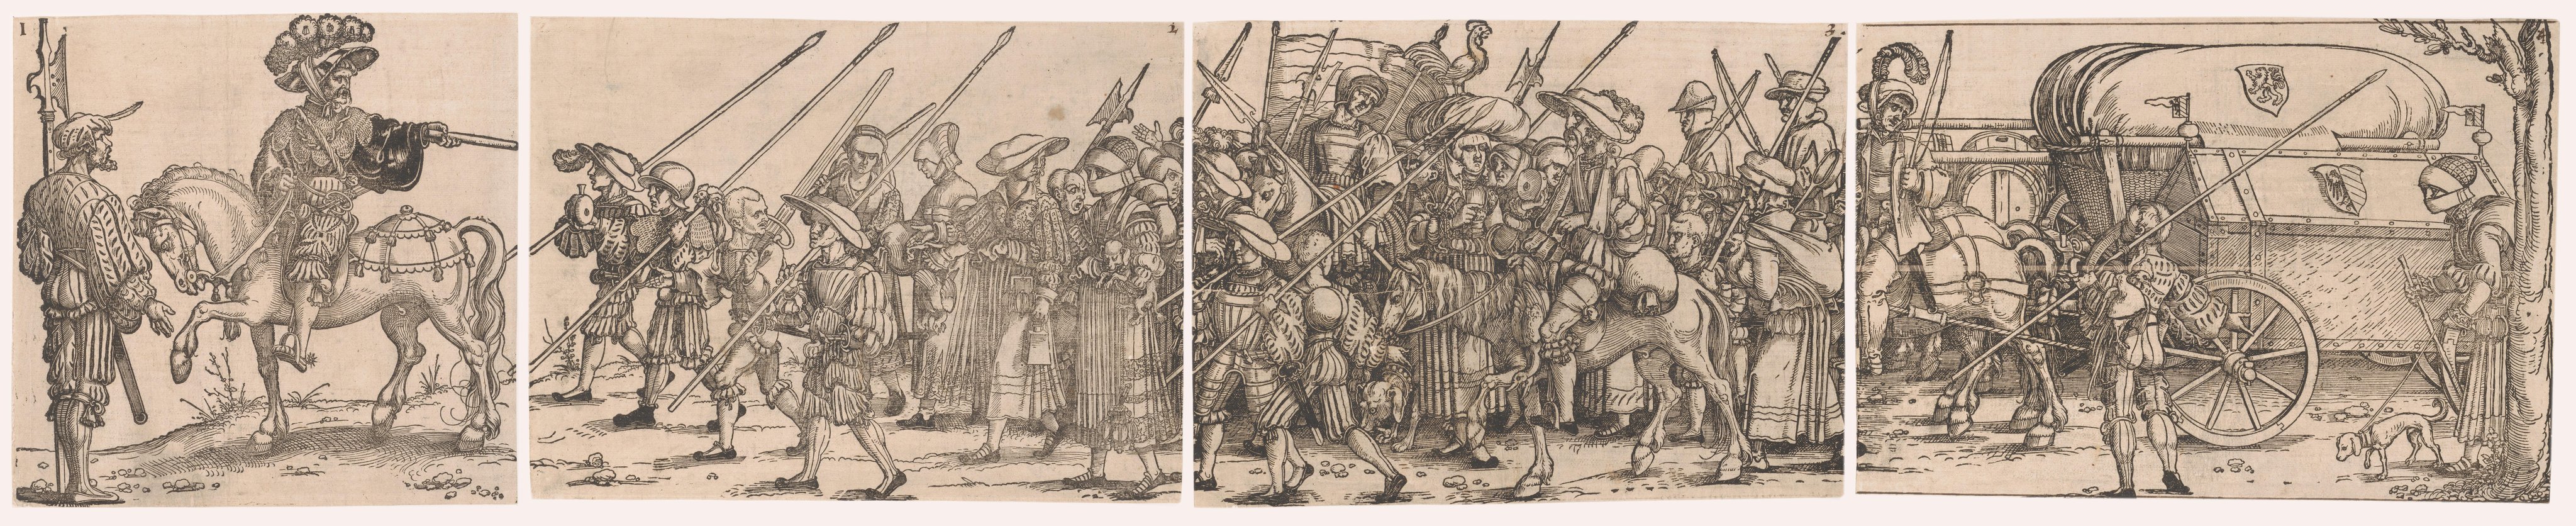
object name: print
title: Soldatenoptocht naar links, bestaande uit vier delen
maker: Anonymous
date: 1510-1550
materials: paper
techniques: woodcut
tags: military parade, pageant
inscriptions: number: ‘1 t/m 4’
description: Dit object is omwille van een betere presentatie virtueel samengevoegd maar bestaat fysiek uit losse onderdelen. De nummering loopt van links naar rechts.